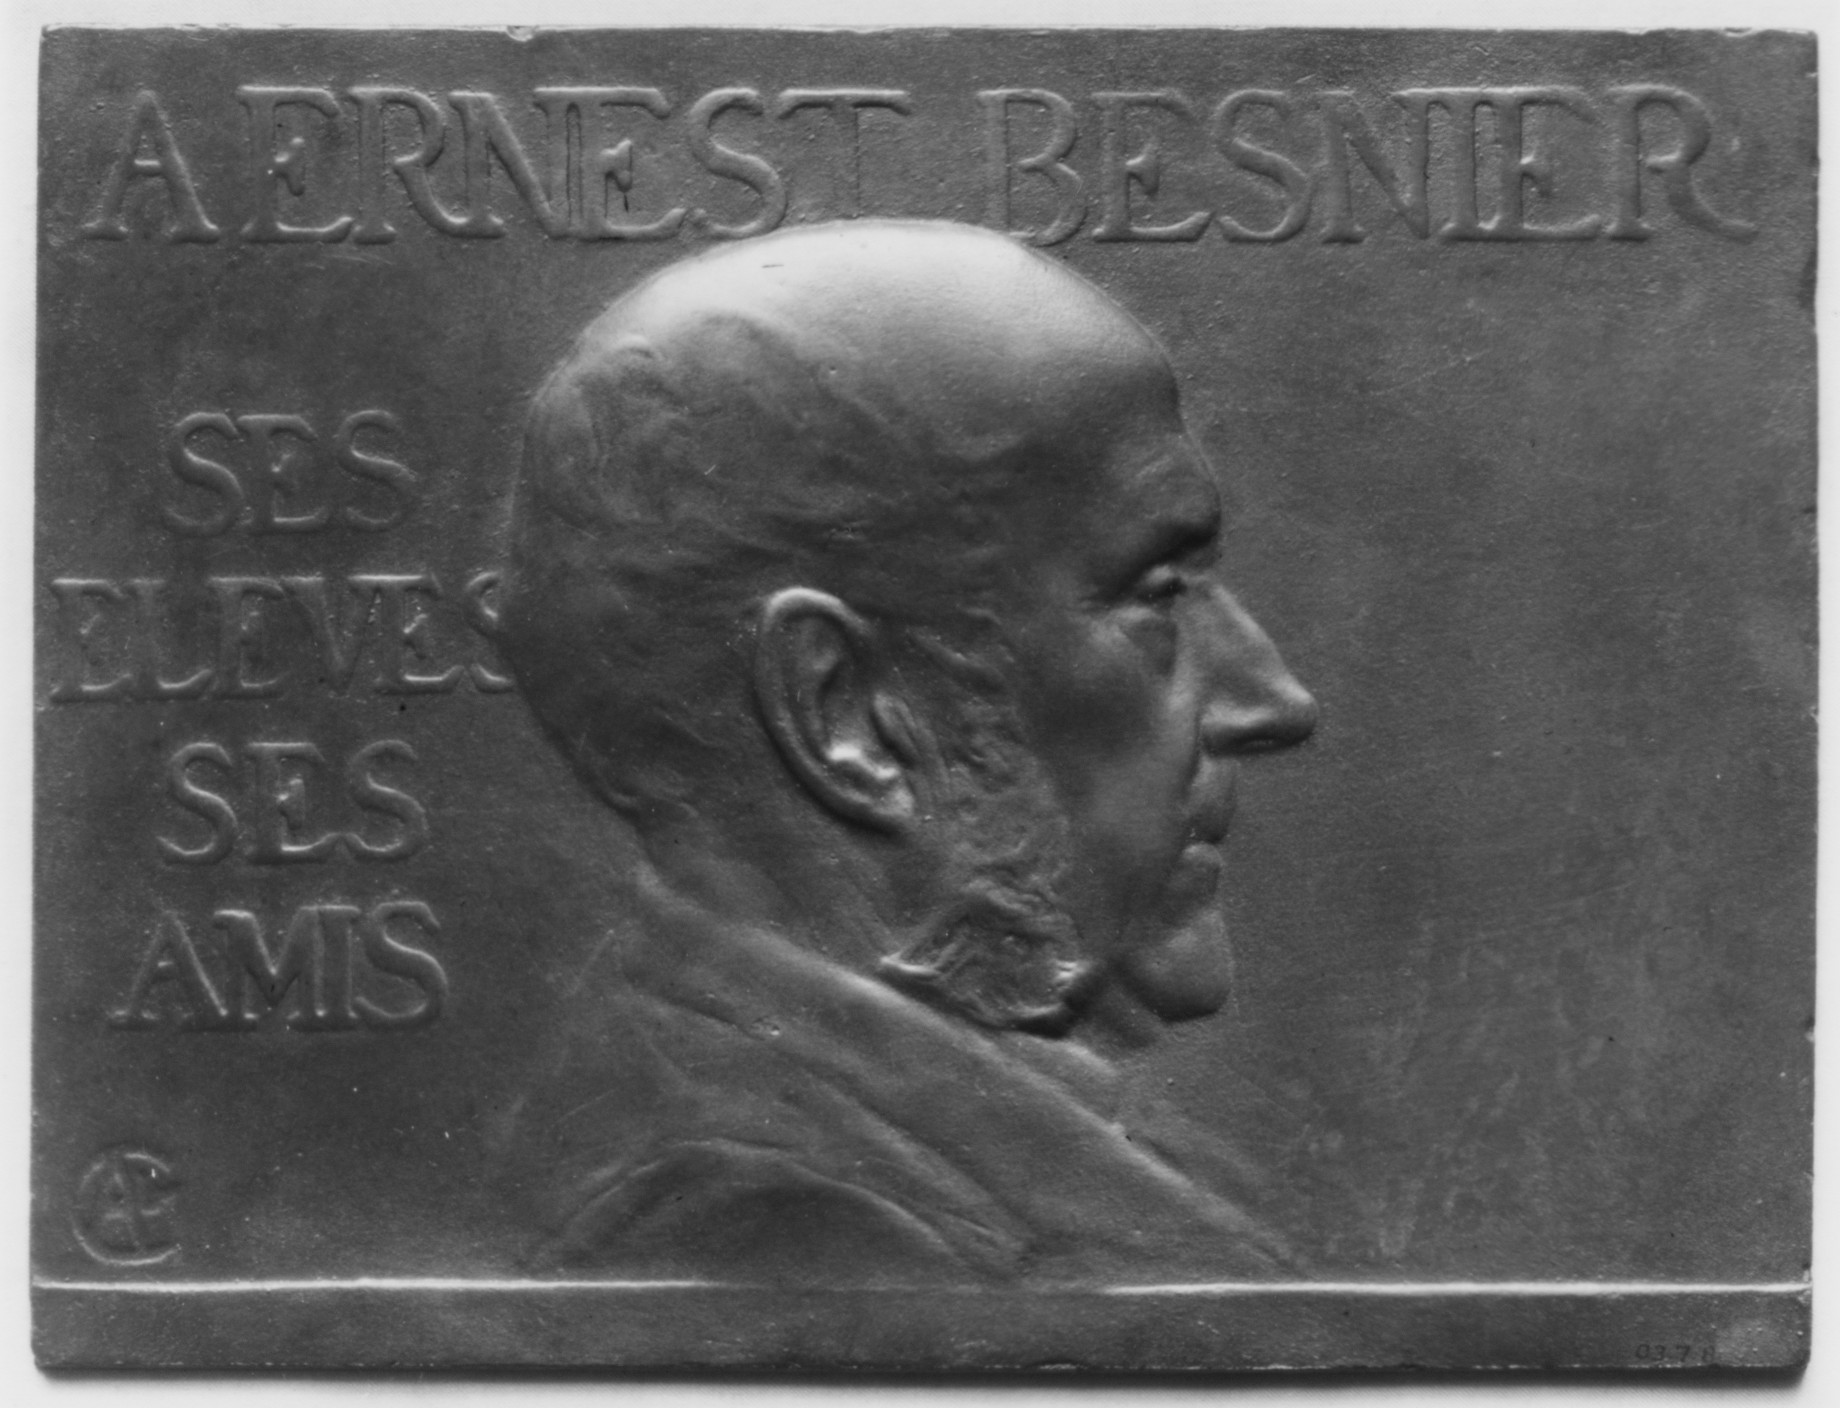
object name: plaque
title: Portrait of Dr. Ernest Besnier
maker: alexandre-louis-marie charpentier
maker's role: artist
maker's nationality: french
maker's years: 1856-1909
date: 1867-1900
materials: bronze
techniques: casting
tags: men,profiles